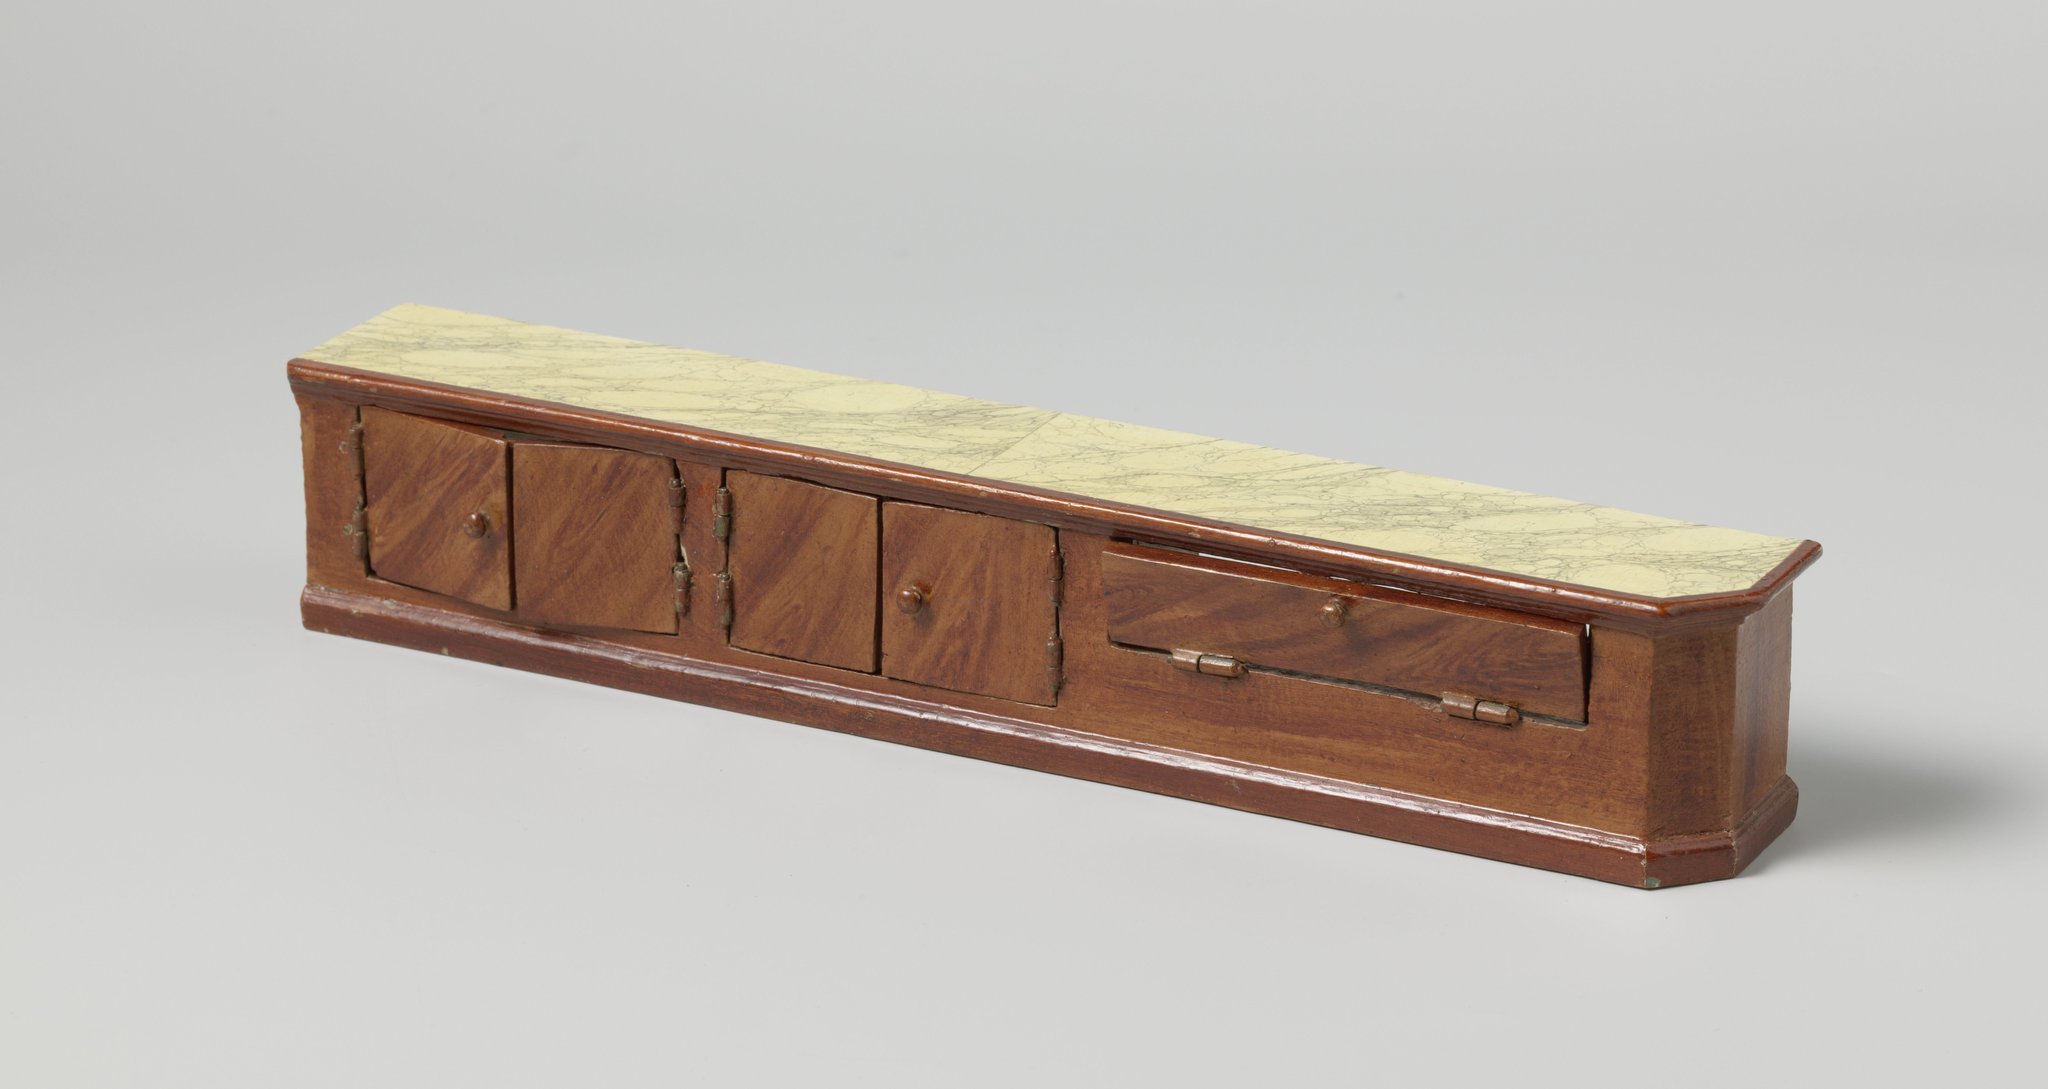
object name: miniature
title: Aanrecht met twee kasten en een gemarmerd blad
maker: Anonymous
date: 1750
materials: wood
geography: amsterdam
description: Aanrecht van geschilderd eikenhout, het blad gemarmerd als keukenvloer en de rest gehout als kozijnen, schoorsteenkap en pomp. In het aanrecht twee kasten met dubbele, openslaande deuren waarin een legplank en een breed vak met neerslaande klep (turfbak ?)